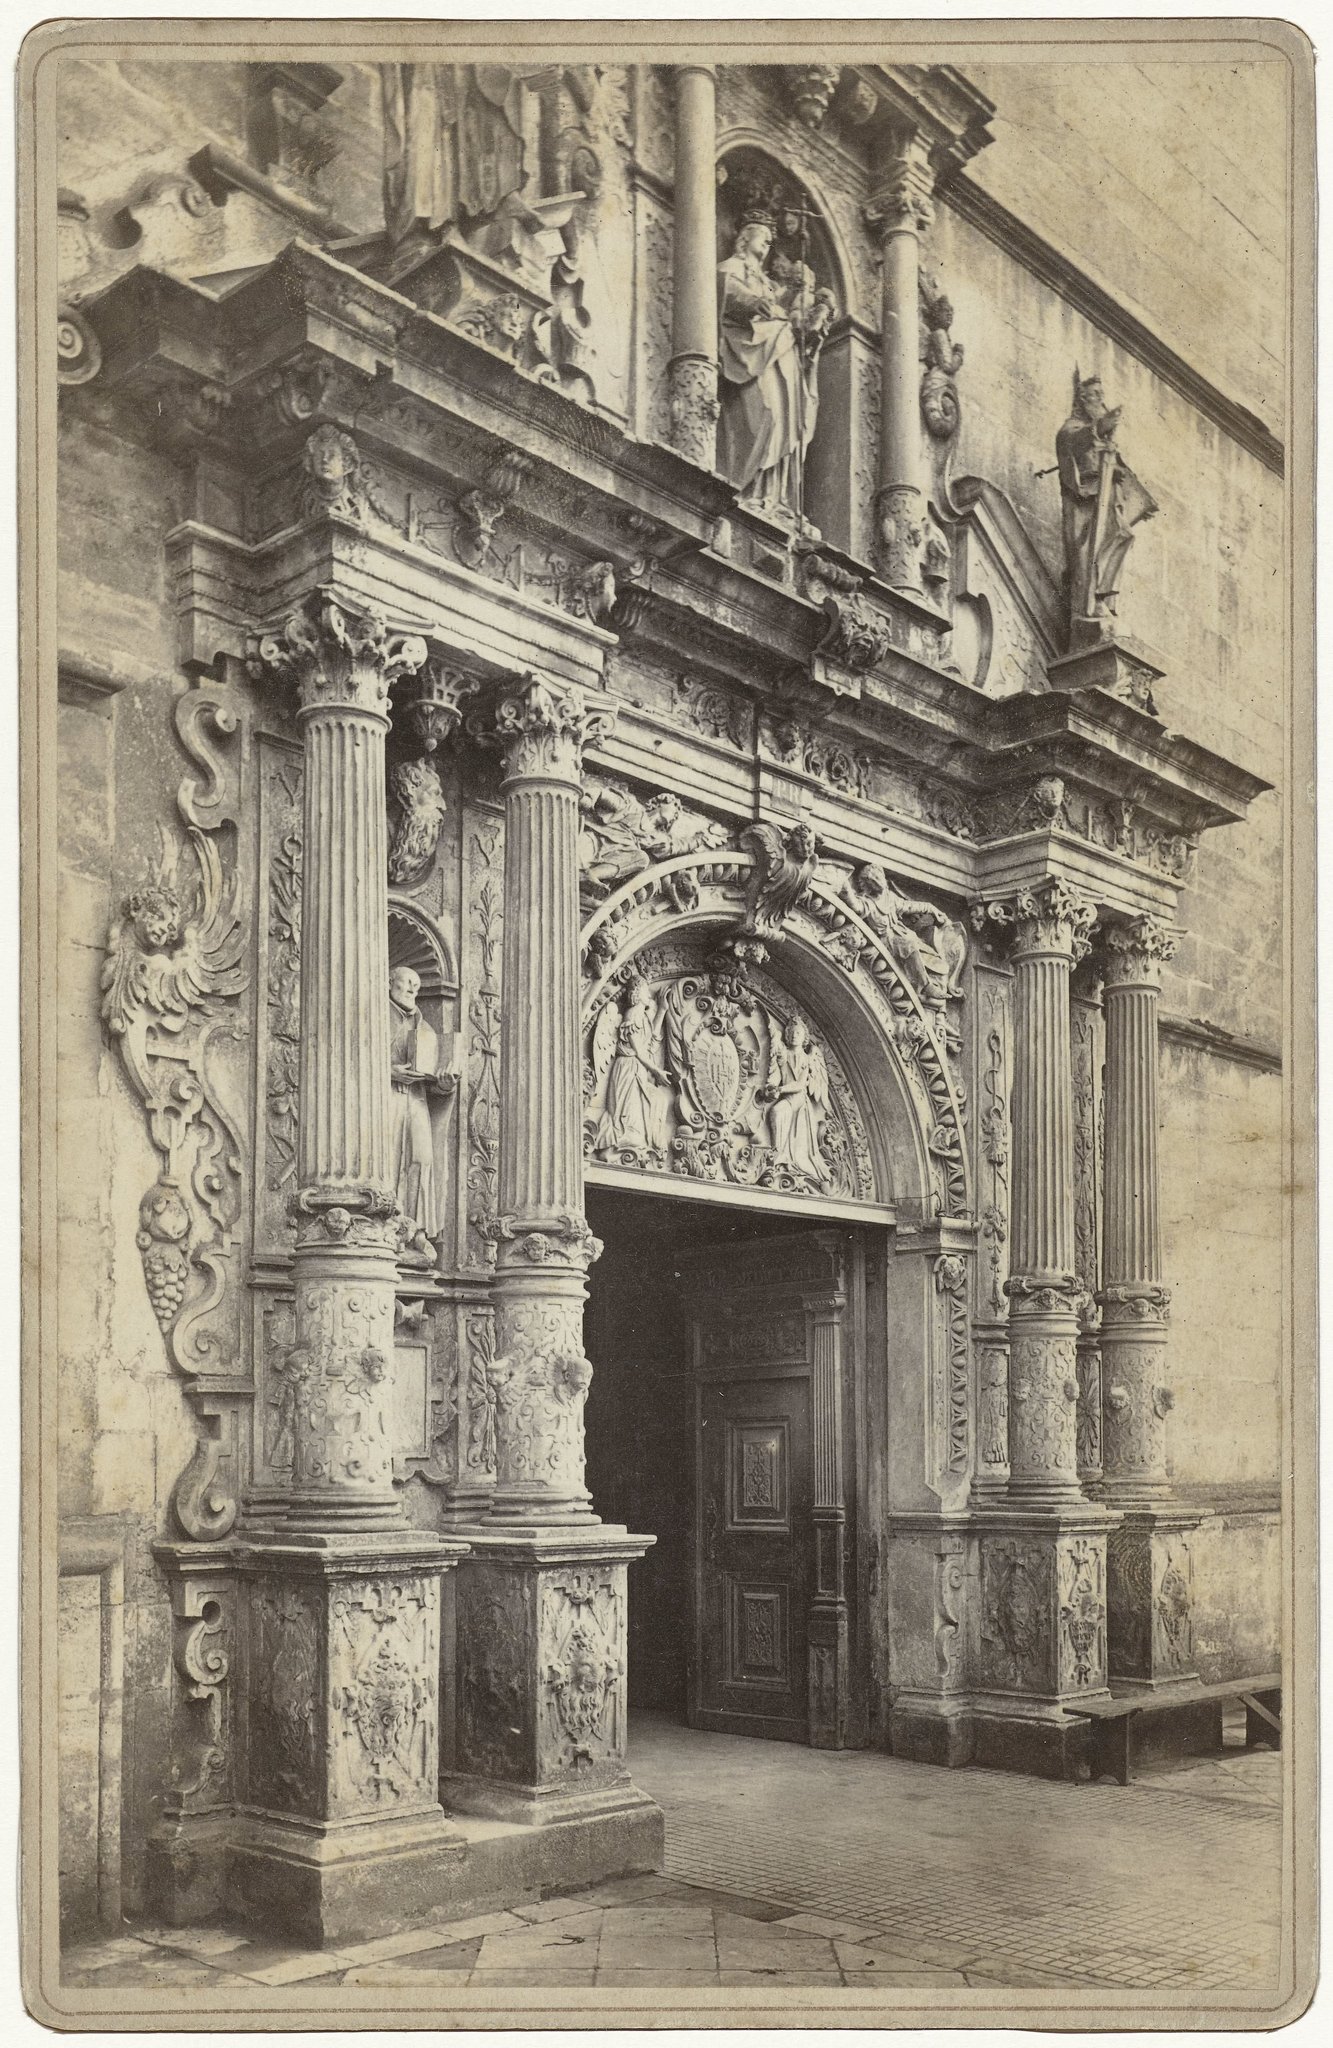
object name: cabinet photograph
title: Noordelijk portaal van de Kathedraal van Luxemburg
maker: Anonymous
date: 1859-1890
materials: cardboard, paper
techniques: albumen print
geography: great britain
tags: parts of church exterior and annexes: portal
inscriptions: number: ‘11566’